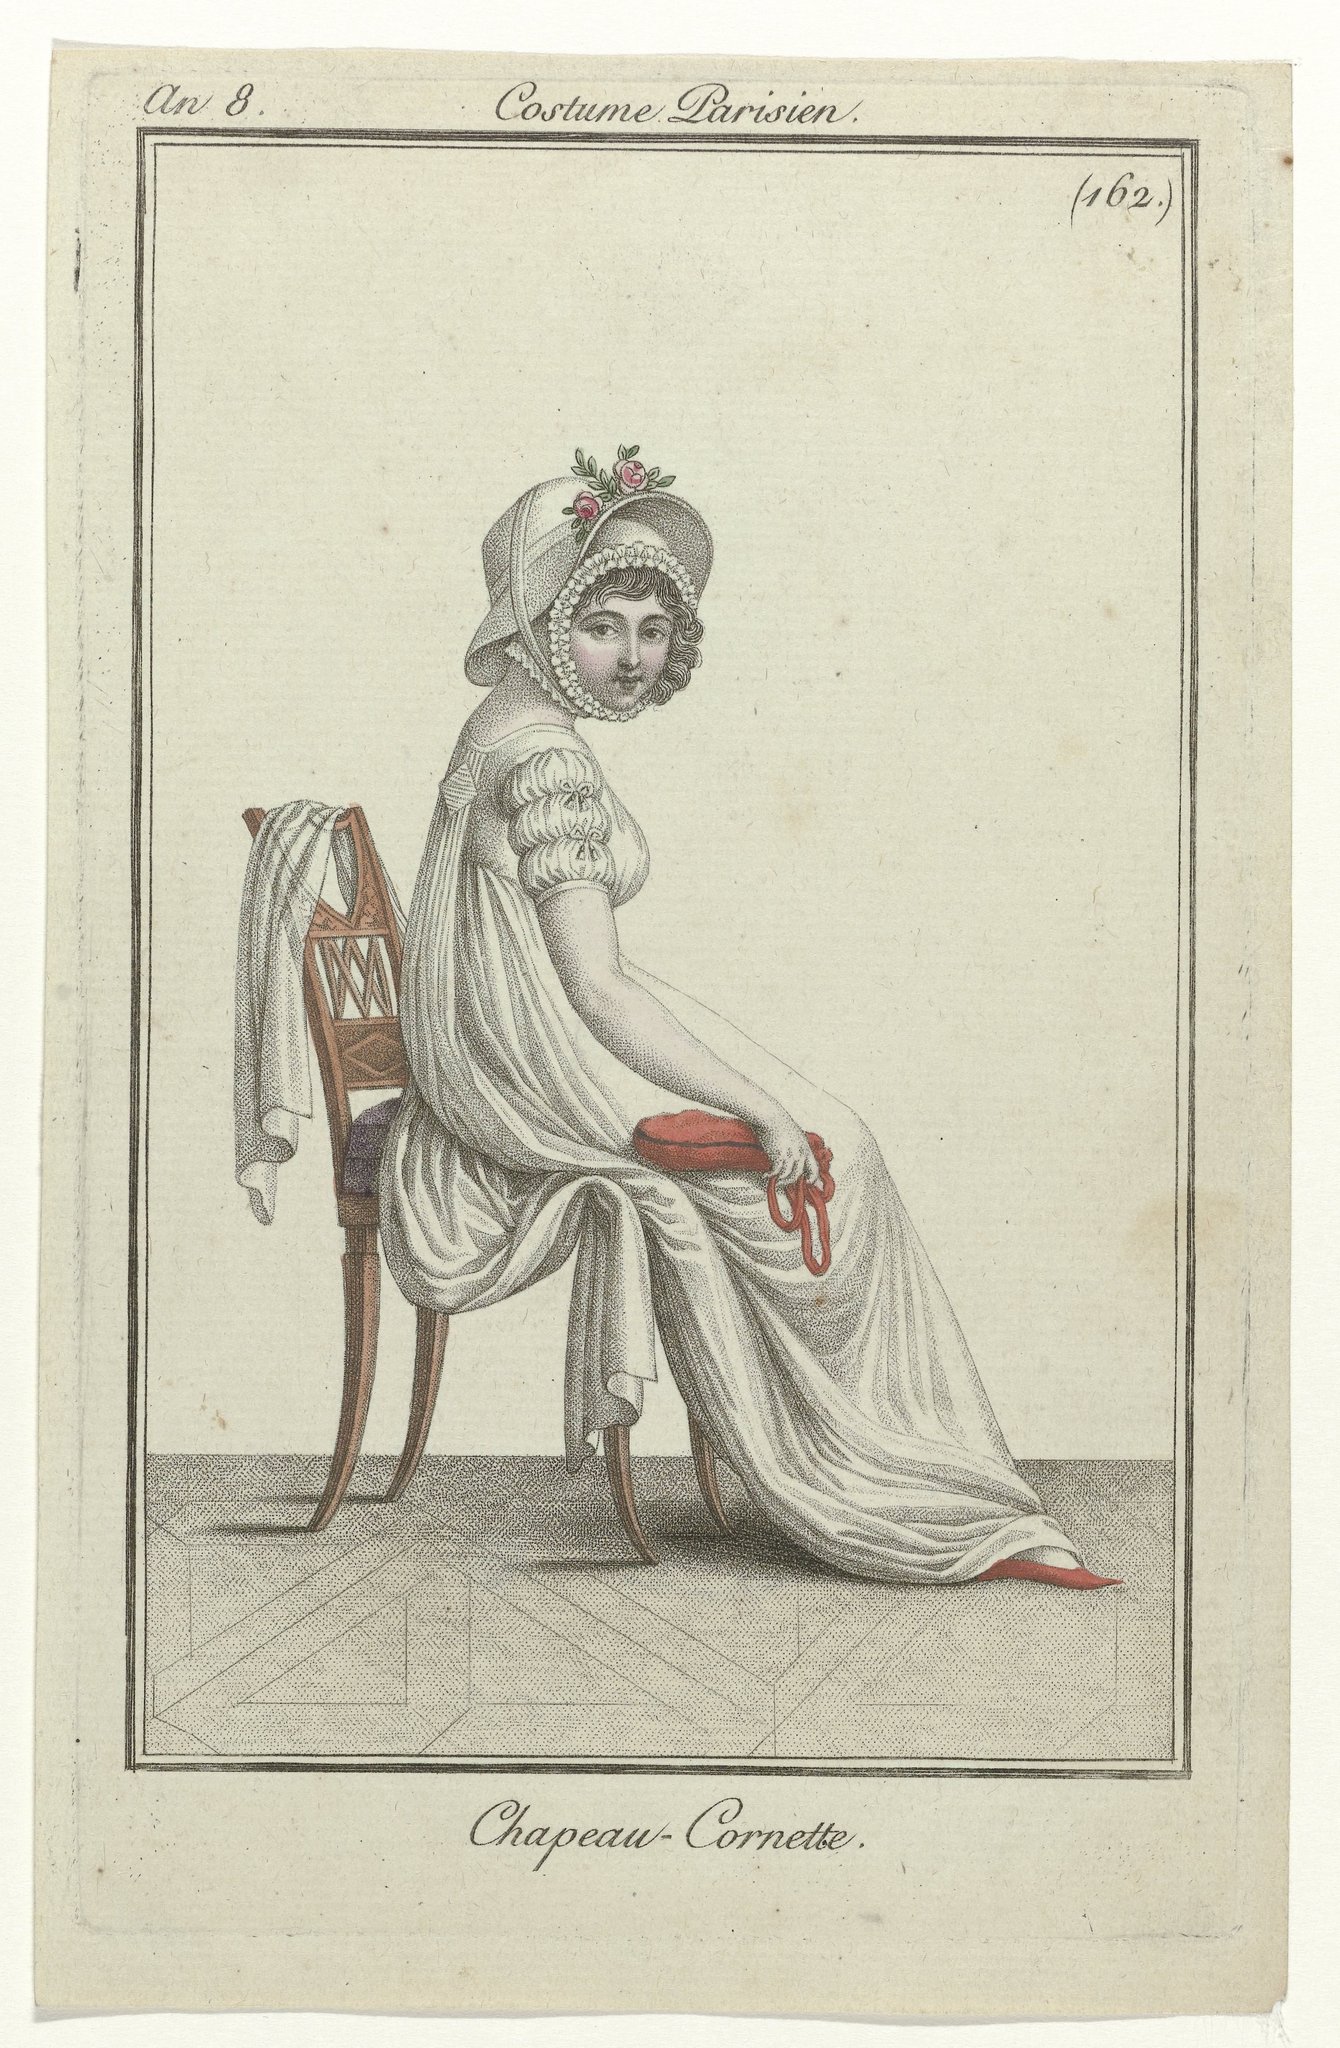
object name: fashion print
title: Journal des Dames et des Modes, Costume Parisien, 7 octobre 1799, An 8 (162) : Chapeau-Cornette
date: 1799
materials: paper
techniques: engraving, hand coloring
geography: paris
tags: clothing for the upper part of the body (shawl) (+ women's clothes), bag (reticule) (+ women's clothes), head-gear (cornette) (+ women's clothes), fashion plates, head-gear: hat (+ women's clothes), shoes, sandals (+ women's clothes), dress, gown (+ women's clothes)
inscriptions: caption: ‘Chapeau-Cornette’, title: ‘Costume Parisien.’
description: 'Chapeau-Cornette' versierd met bloemen. Japon met korte gerimpelde mouwen met strikken. Accessoires: reticule in de hand, platte schoen met puntige neus, doorzichtige sjaal over de rugleuning. De prent maakt deel uit van het modetijdschrift Journal des Dames et des Modes, uitgegeven door Pierre de la Mésangère, Parijs, 1797-1839.